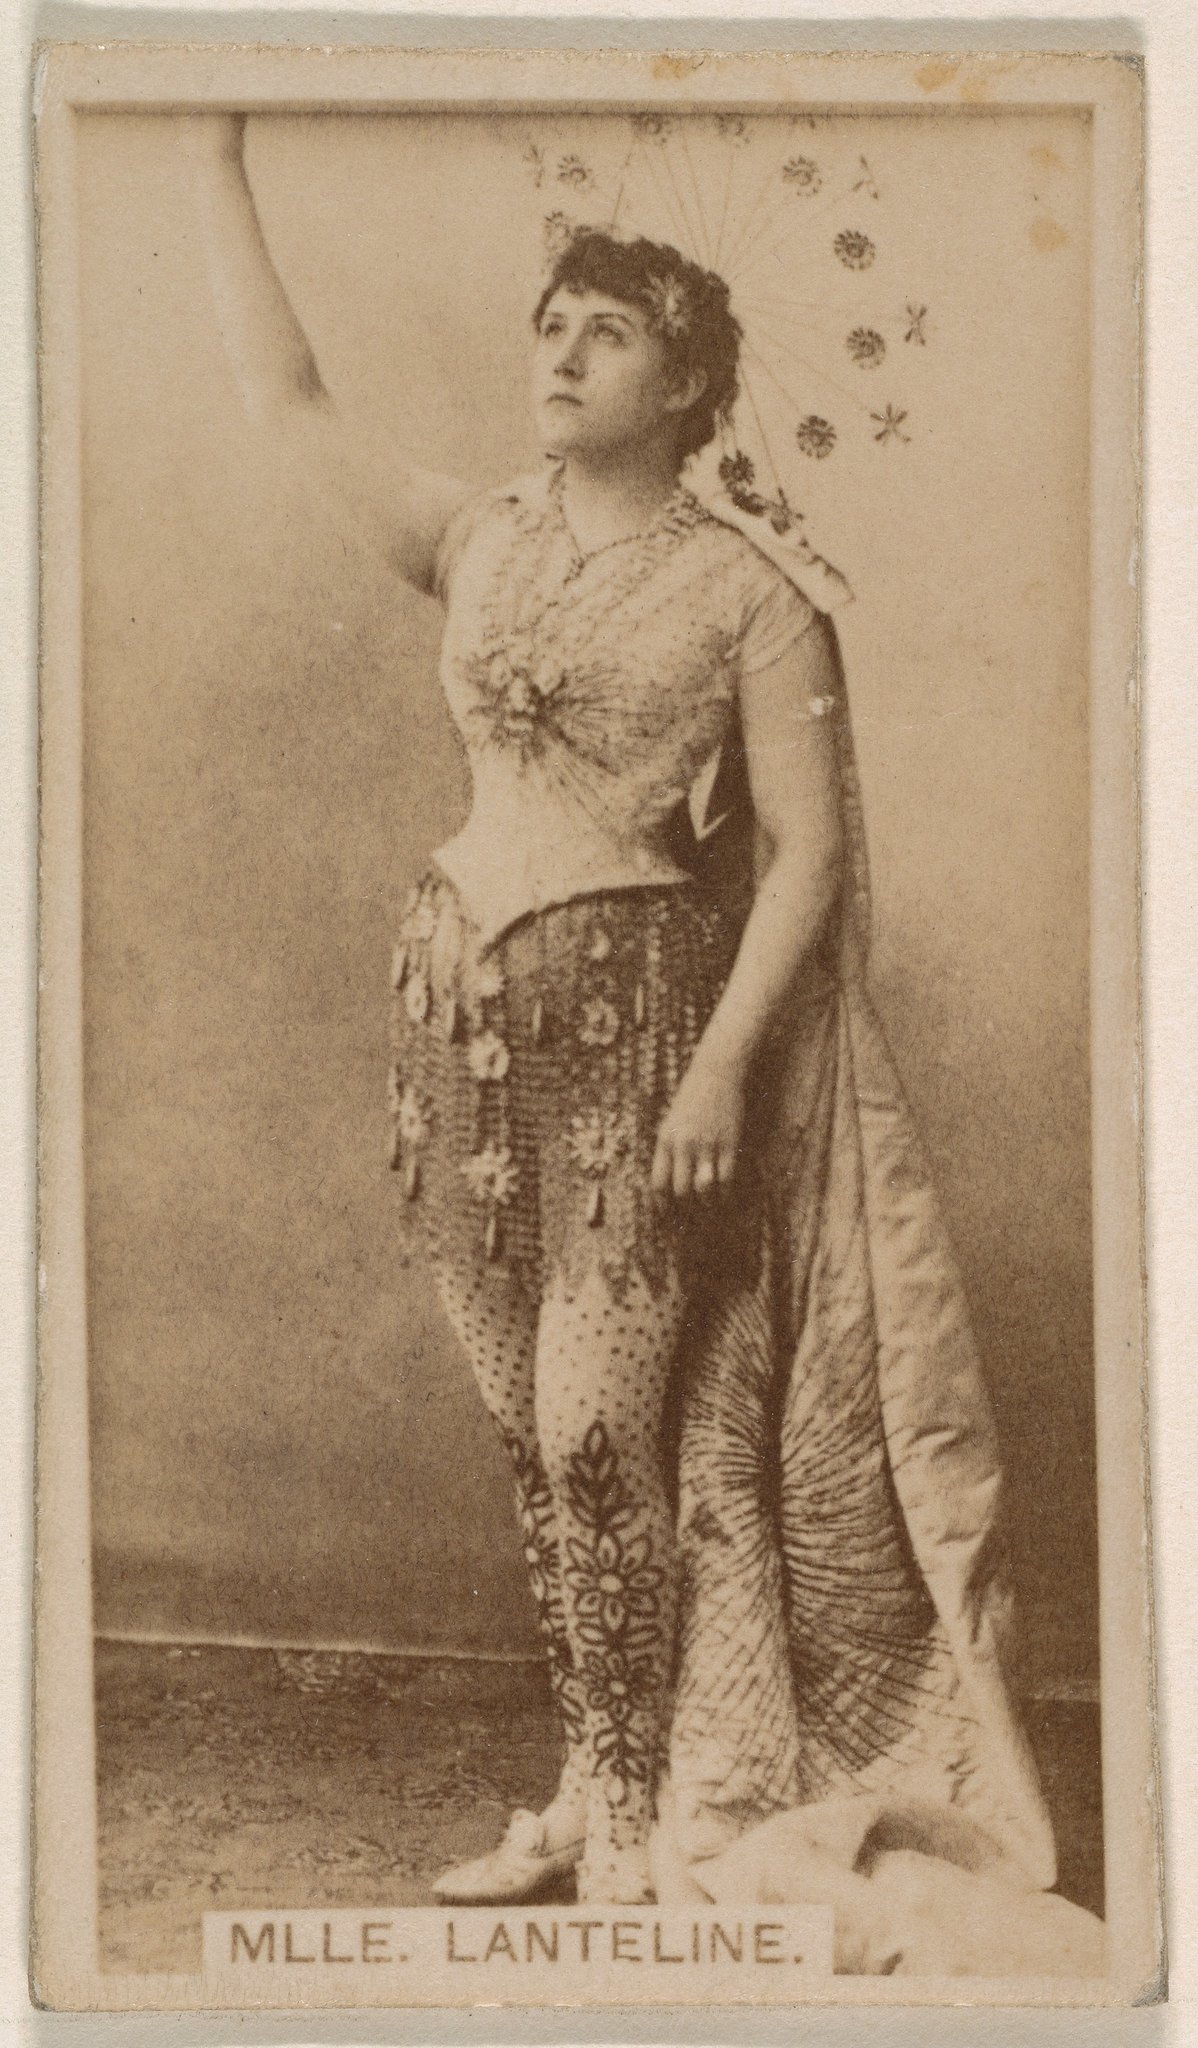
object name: photograph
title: Mlle. Lanteline, from the Actresses series (N245) issued by Kinney Brothers to promote Sweet Caporal Cigarettes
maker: kinney brothers tobacco company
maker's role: publisher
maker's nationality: american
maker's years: 1869-2011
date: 1890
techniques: albumen silver print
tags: portraits,women,actresses